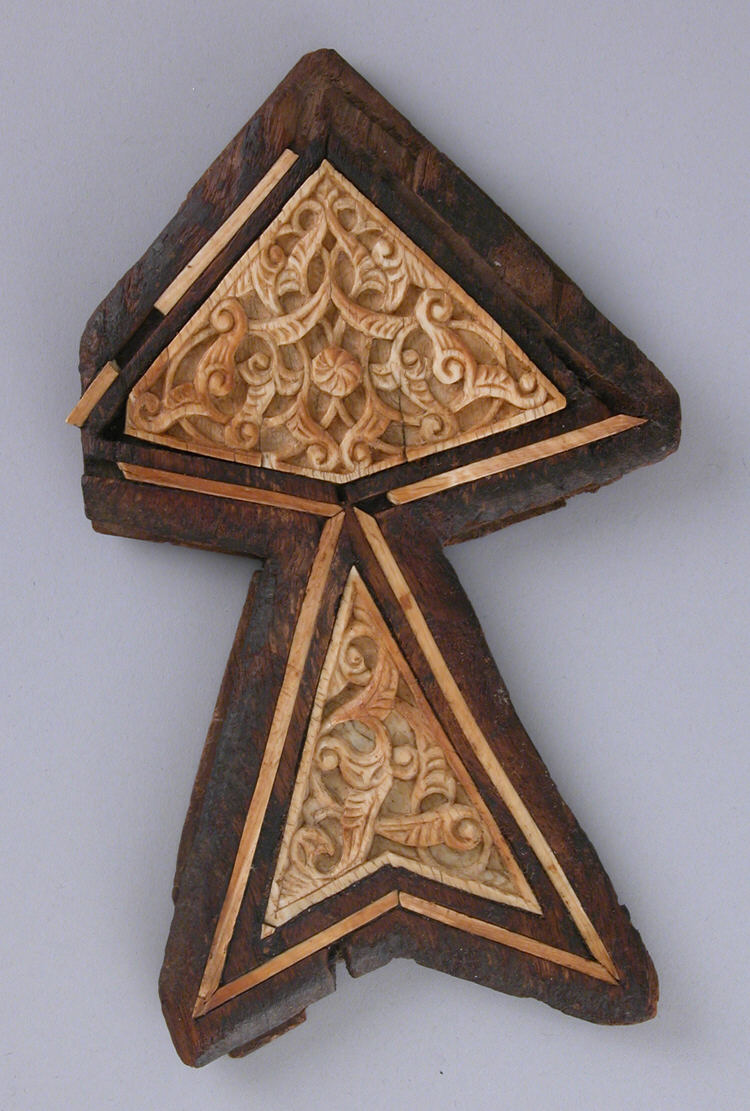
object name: panel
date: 1401-1500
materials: ivory, wood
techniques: carving, inlay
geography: egypt